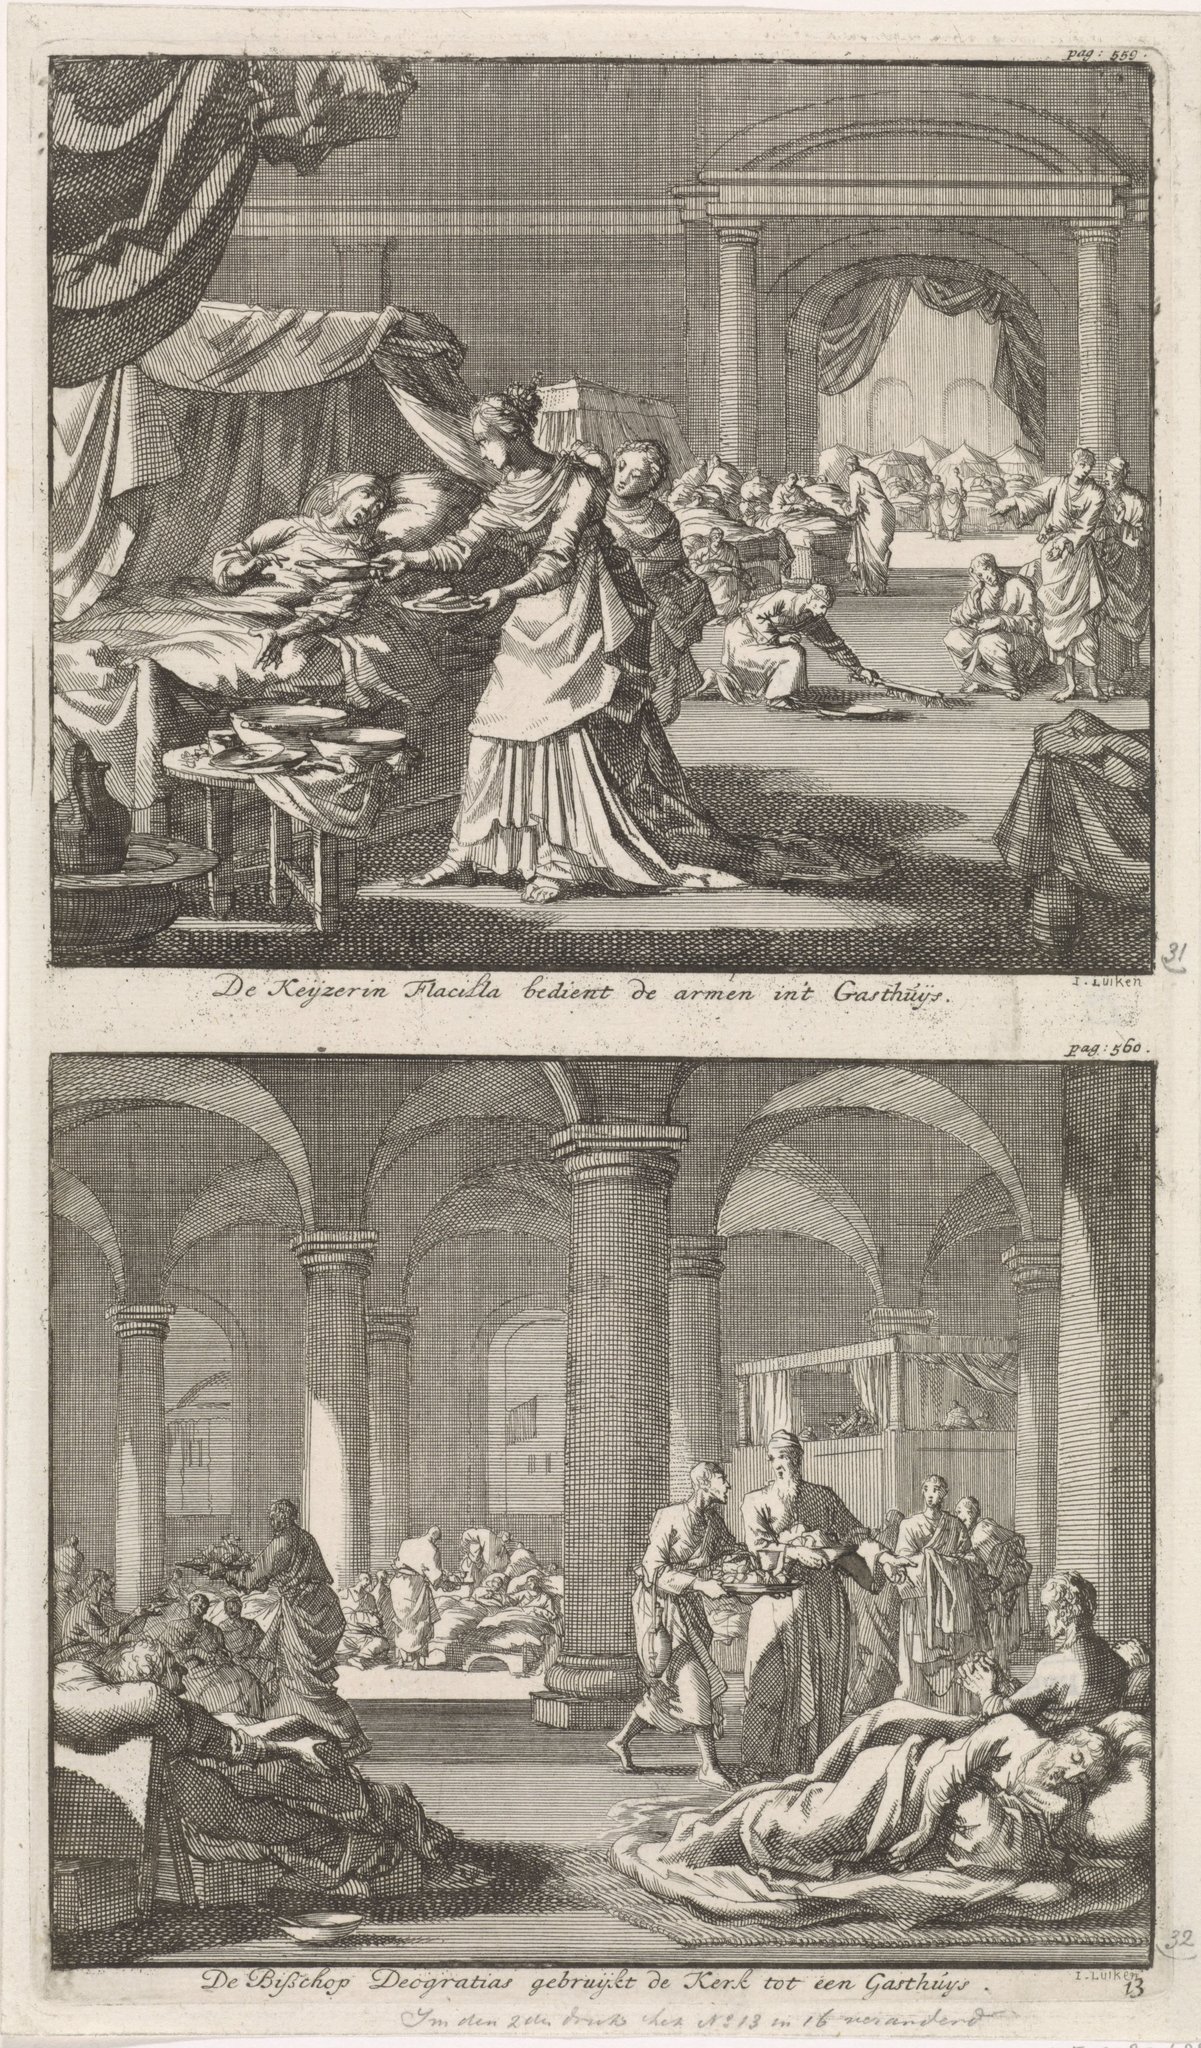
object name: print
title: Heilige keizerin Flaccilla verpleegt de armen en zieken en de heilige Deogratias verzorgt zieken in de kerk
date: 1700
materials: paper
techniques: etching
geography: amsterdam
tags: the early christian churches, e.g. armenians, copts, syrians, female saints (with name), medical aid and nursing of the sick and wounded, male saints (with name), interior of church, visiting the sick, 'aeger curatur' ~ one of the (seven) acts of mercy, nursing, tending the sick, visiting the sick in hospital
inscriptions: collector's mark: Lugt 2228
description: Twee voorstellingen op een plaat. Boven: de H. keizerin Flaccilla deelt voedsel uit aan een zieke vrouw in het gasthuis. Op de achtergrond andere zieken. Onder: de H. Deogratias, bisschop van Carthago, heeft zijn kerk als ziekenhuis ingericht en verzorgt samen met andere christenen de zieken.